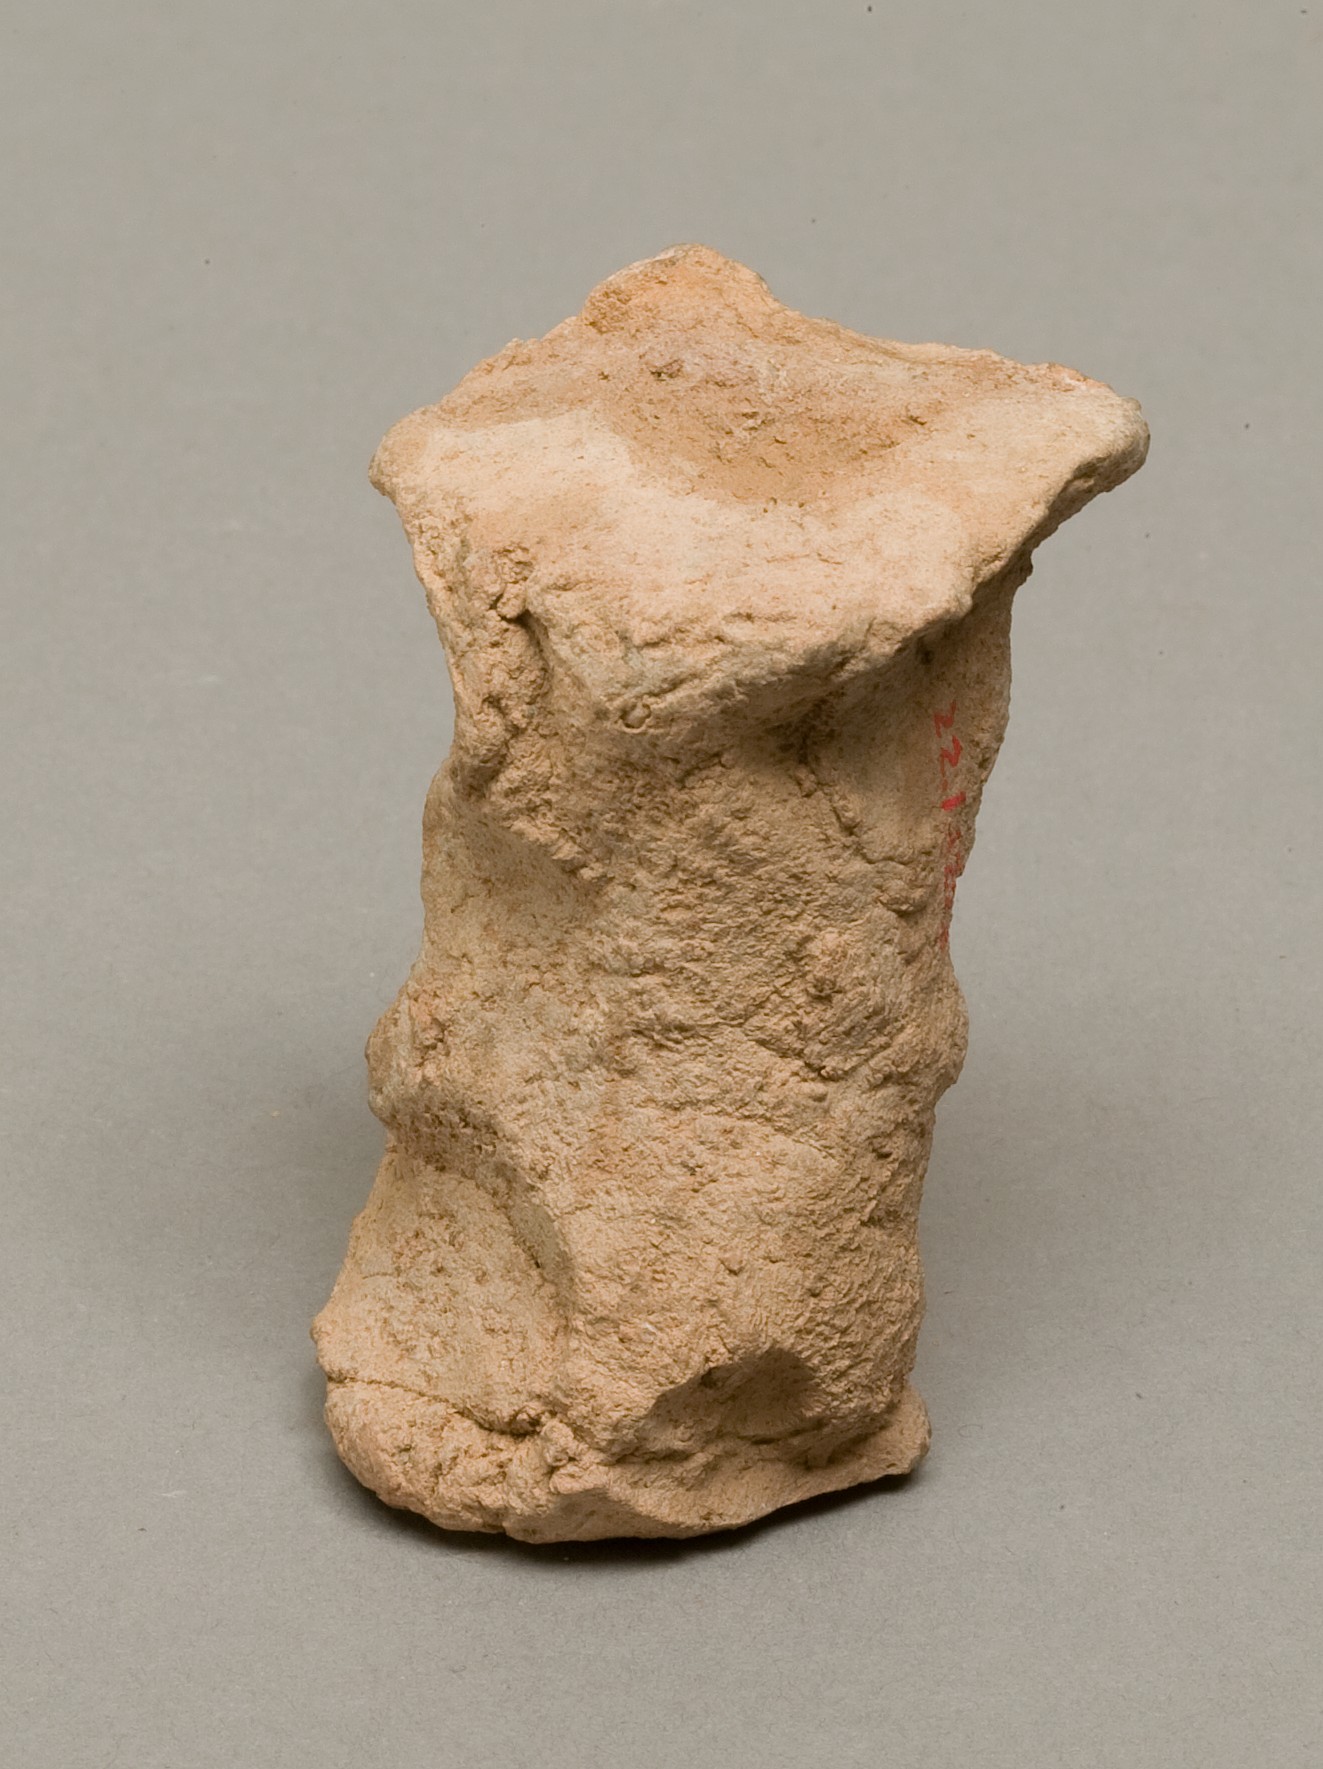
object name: fragment, clay section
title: Faience workshop refuse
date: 1802-1450 BCE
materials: clay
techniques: firing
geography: egypt